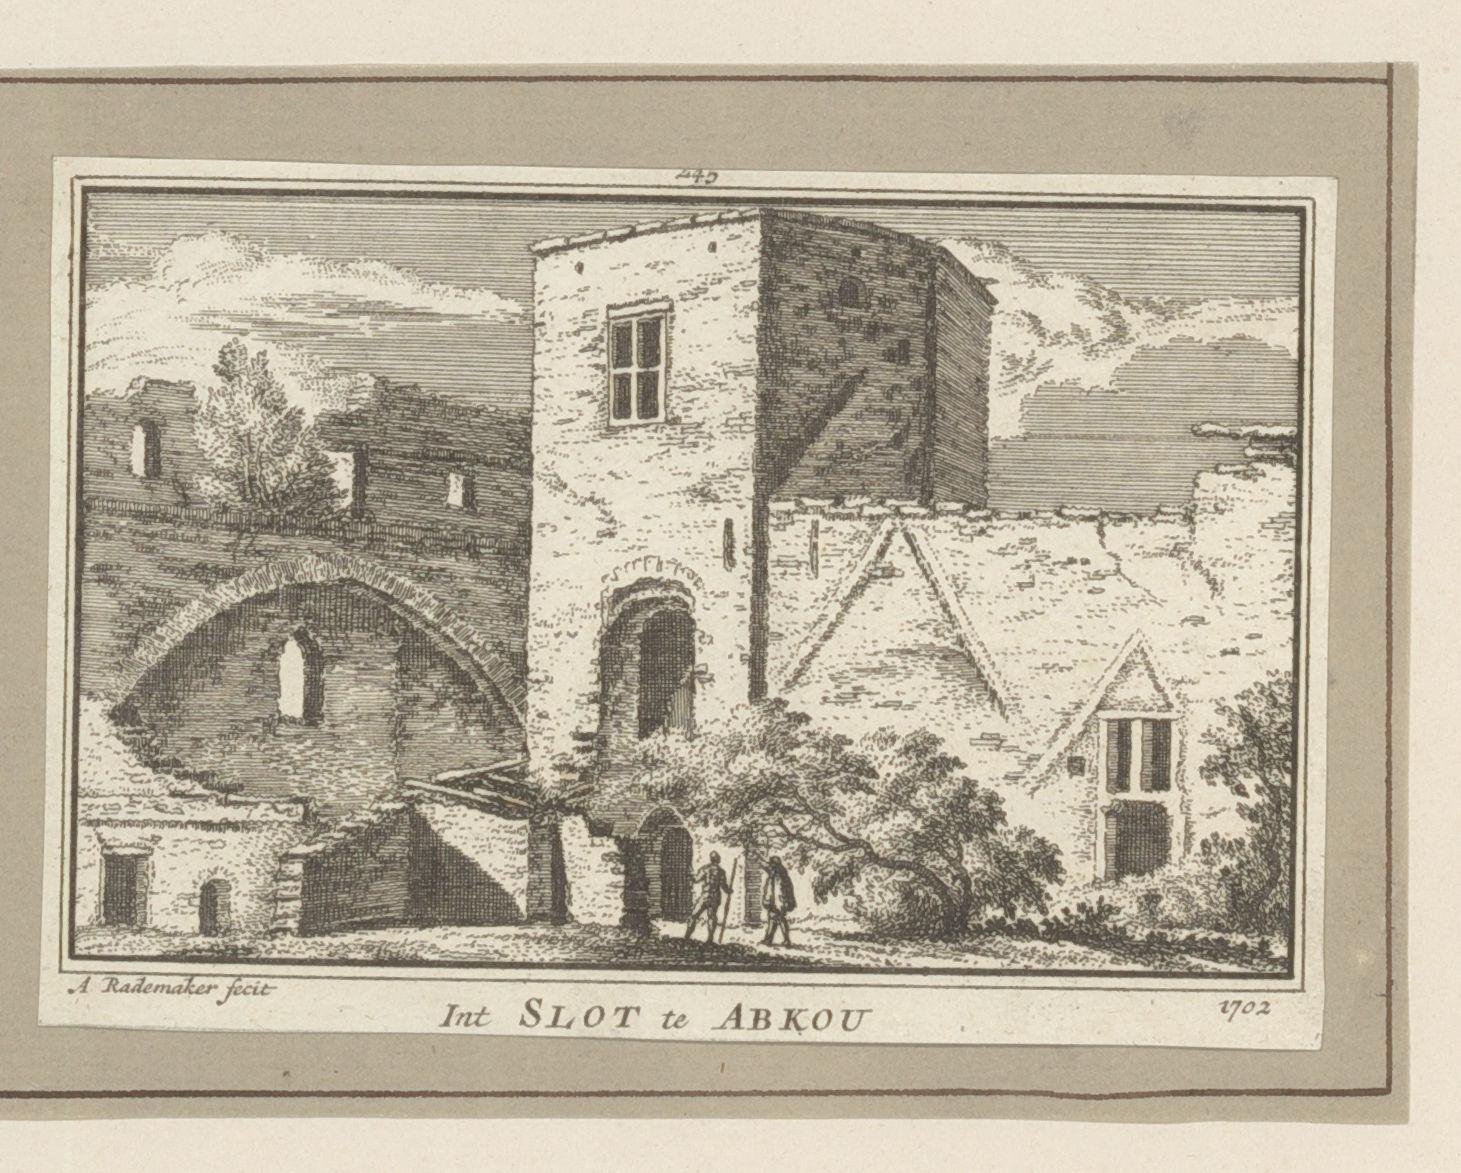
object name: print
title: Gezicht op het interieur van het slot te Abcoude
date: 1702-1733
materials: paper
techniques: engraving, etching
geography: amsterdam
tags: draughtsman at work, ruin of a dwelling, house, castle, etc., utrecht, abcoude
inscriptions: stamp, stamp, collector's mark: Lugt 1641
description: Gezicht op een gedeelte van het interieur van de ruïne van het slot te Abcoude, in de situatie omstreeks 1702. In het midden een zeshoekige toren en op de voorgrond twee figuren. Bovenaan genummerd: 245. Onderwerpsrubrieken binnen de Atlas Zeden en Gewoonten: Zeden en Gewoonten in Engeren Zin, De Woning. Kastelen en buitenplaatsen. Utrecht (vervolg.).